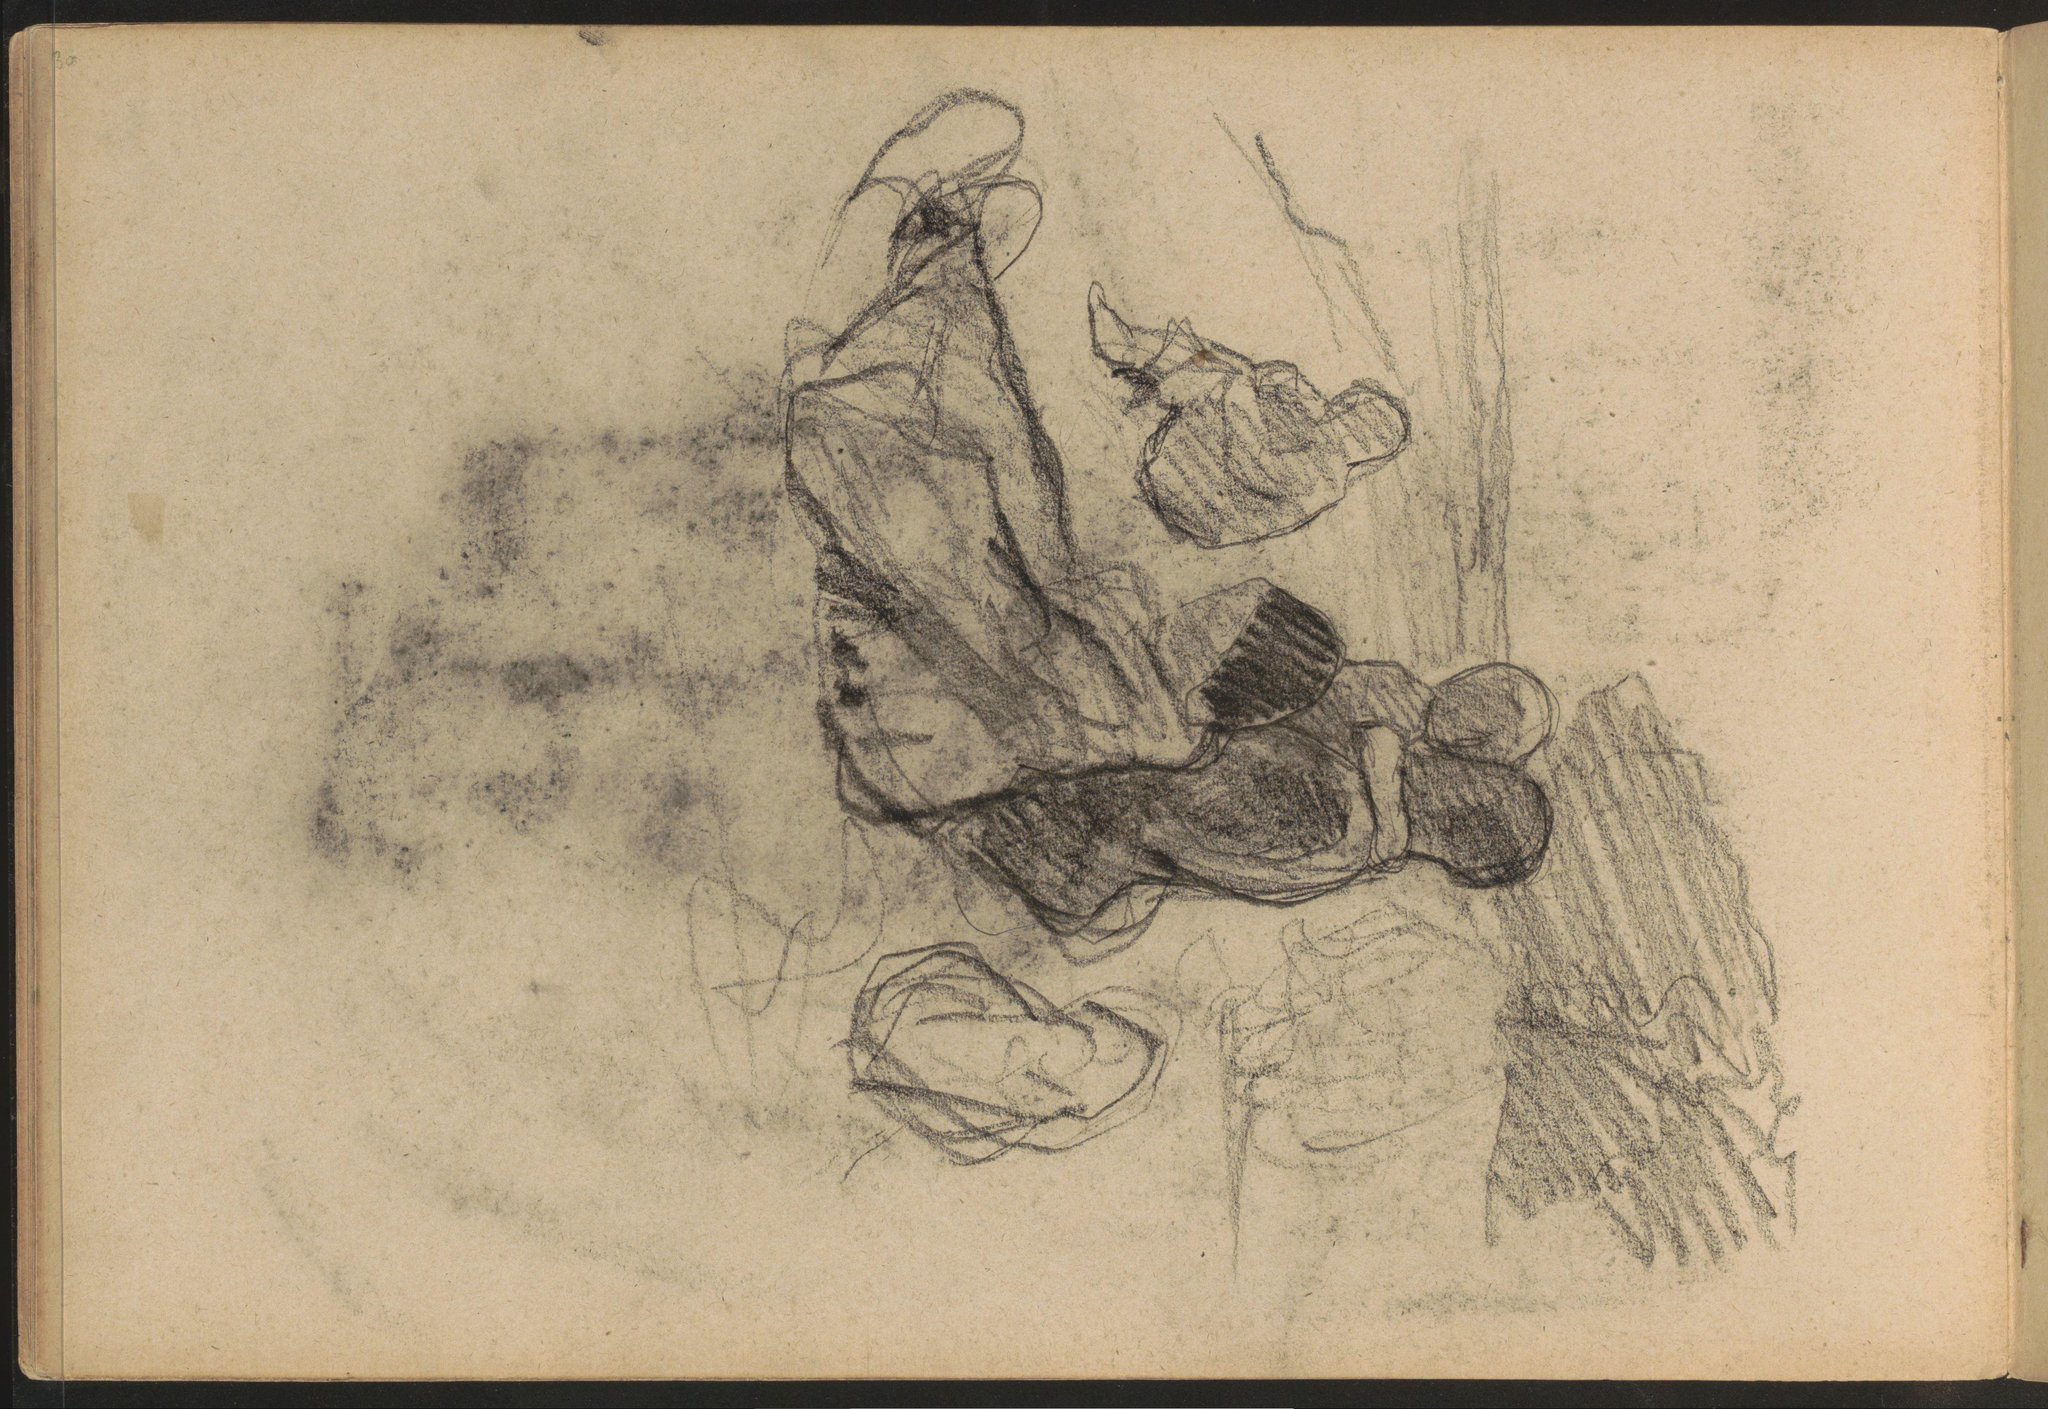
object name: sketchbook leaf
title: Zittende vrouw met drie kinderen in een landschap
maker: willem witsen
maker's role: draughtsman, painter, print maker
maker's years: 1860-1923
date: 1884-1887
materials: chalk, paper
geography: ewijkshoeve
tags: sitting figure - aa - female human figure, landscapes in the temperate zone, mother and child(ren), woman and child(ren) (family group)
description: Pagina 30 uit een schetsboek met 29 bladen.